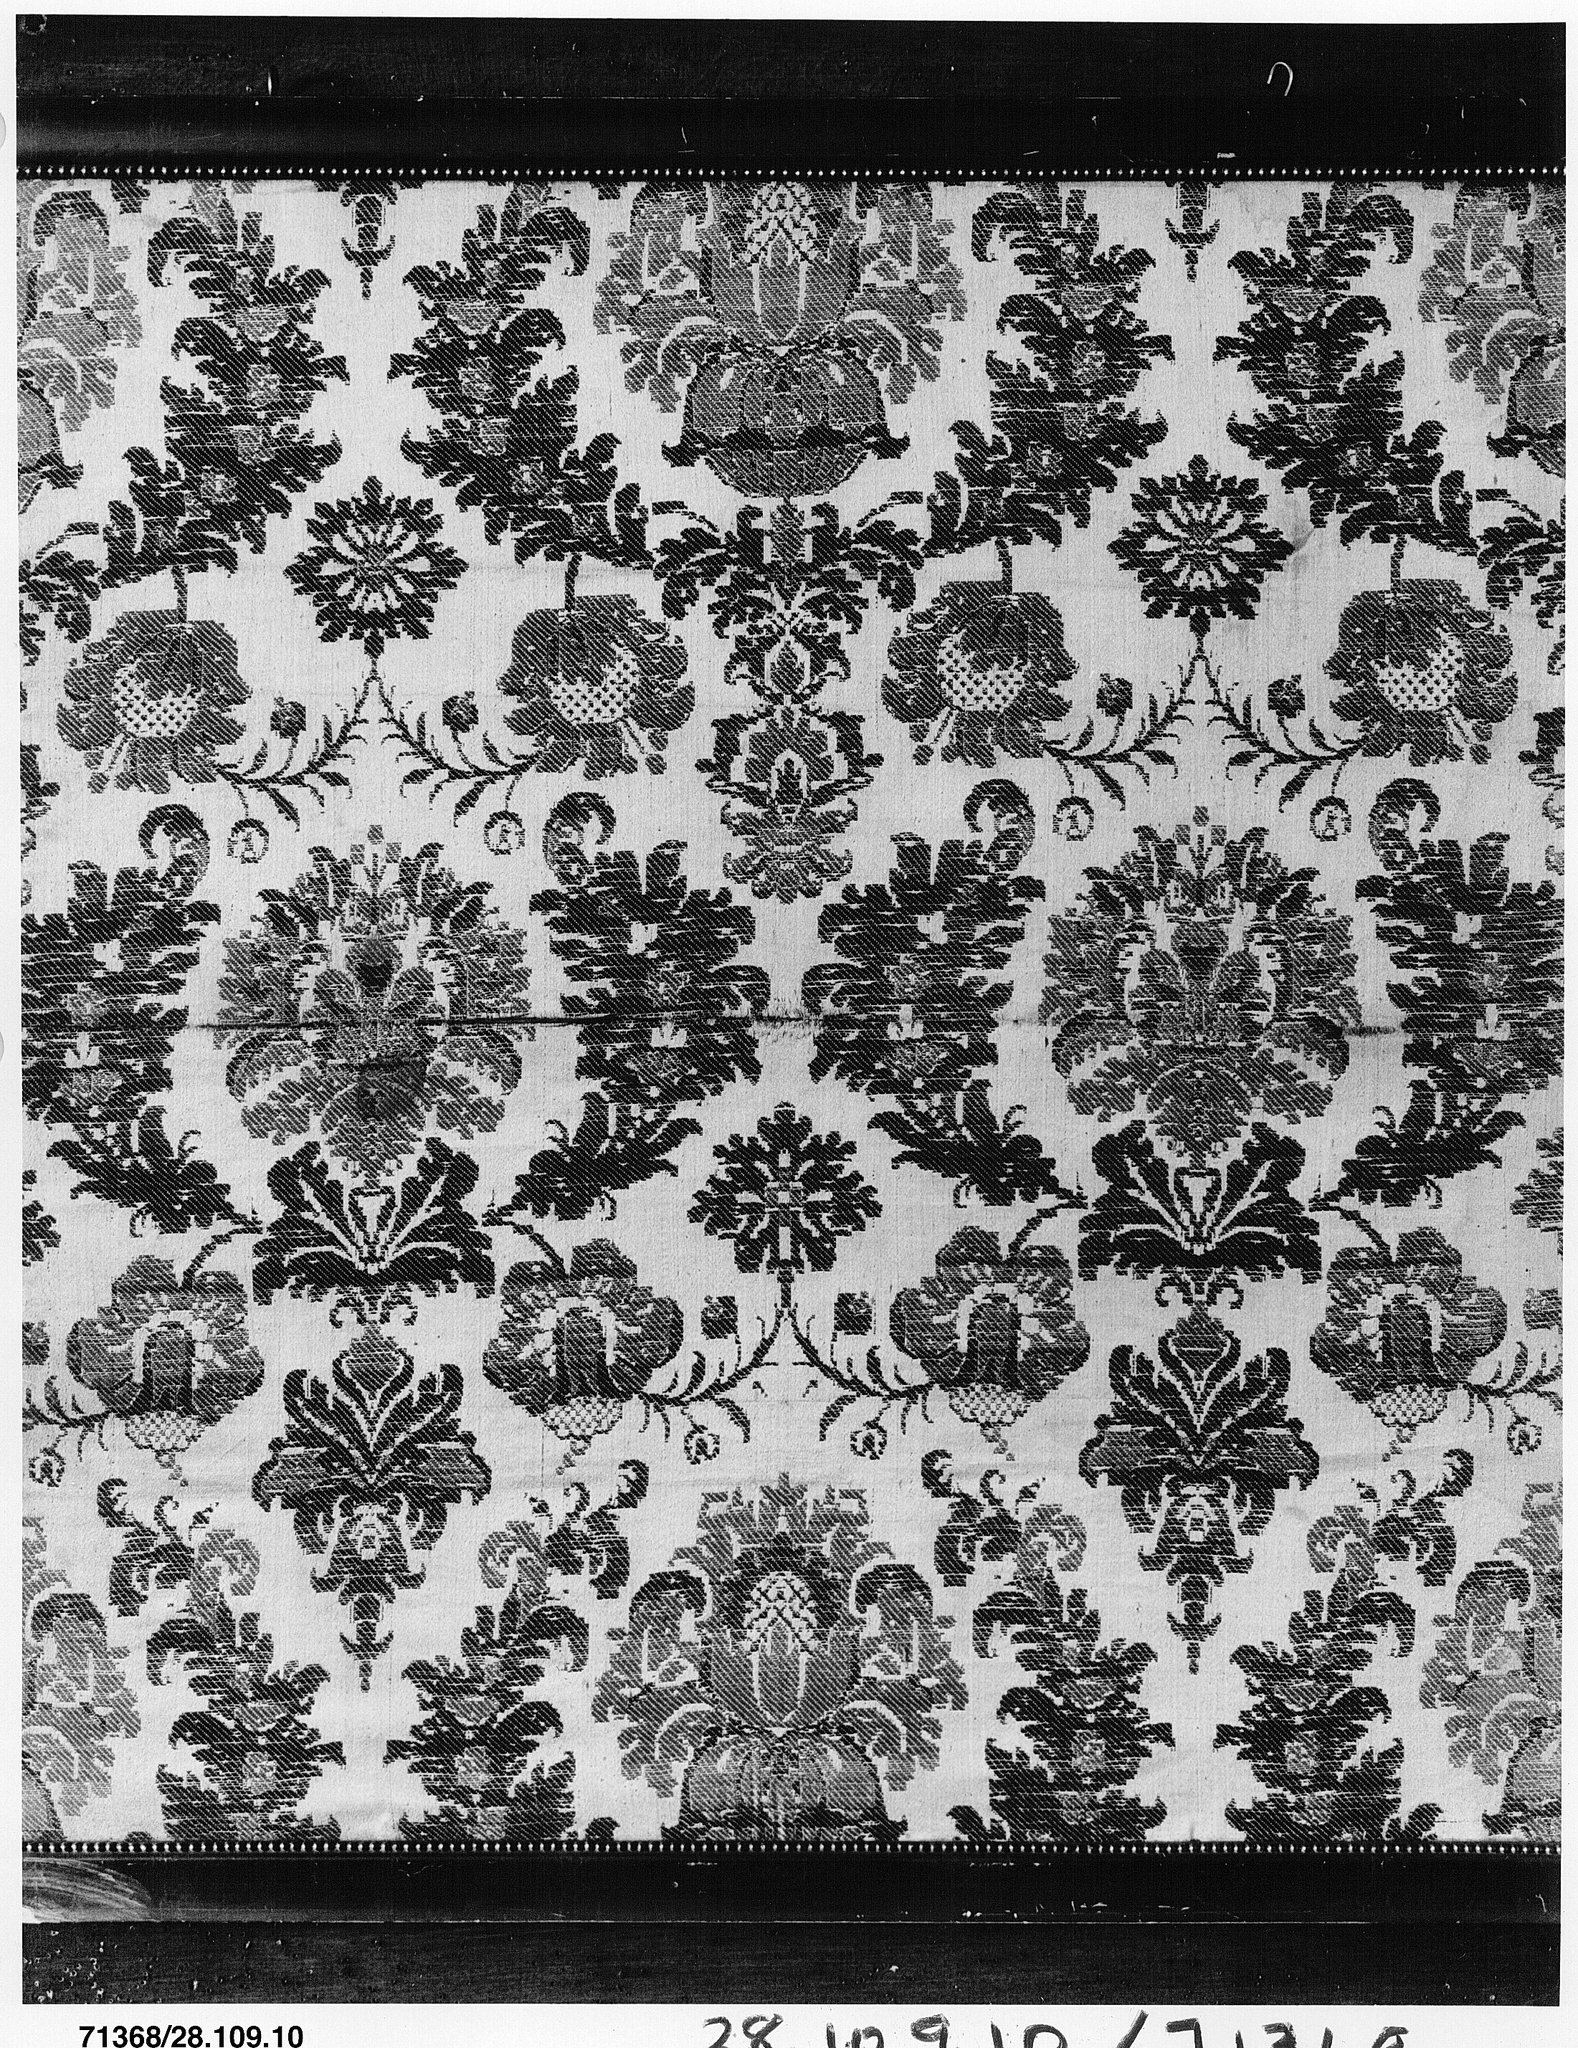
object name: piece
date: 1601-1700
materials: silk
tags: flowers,leaves